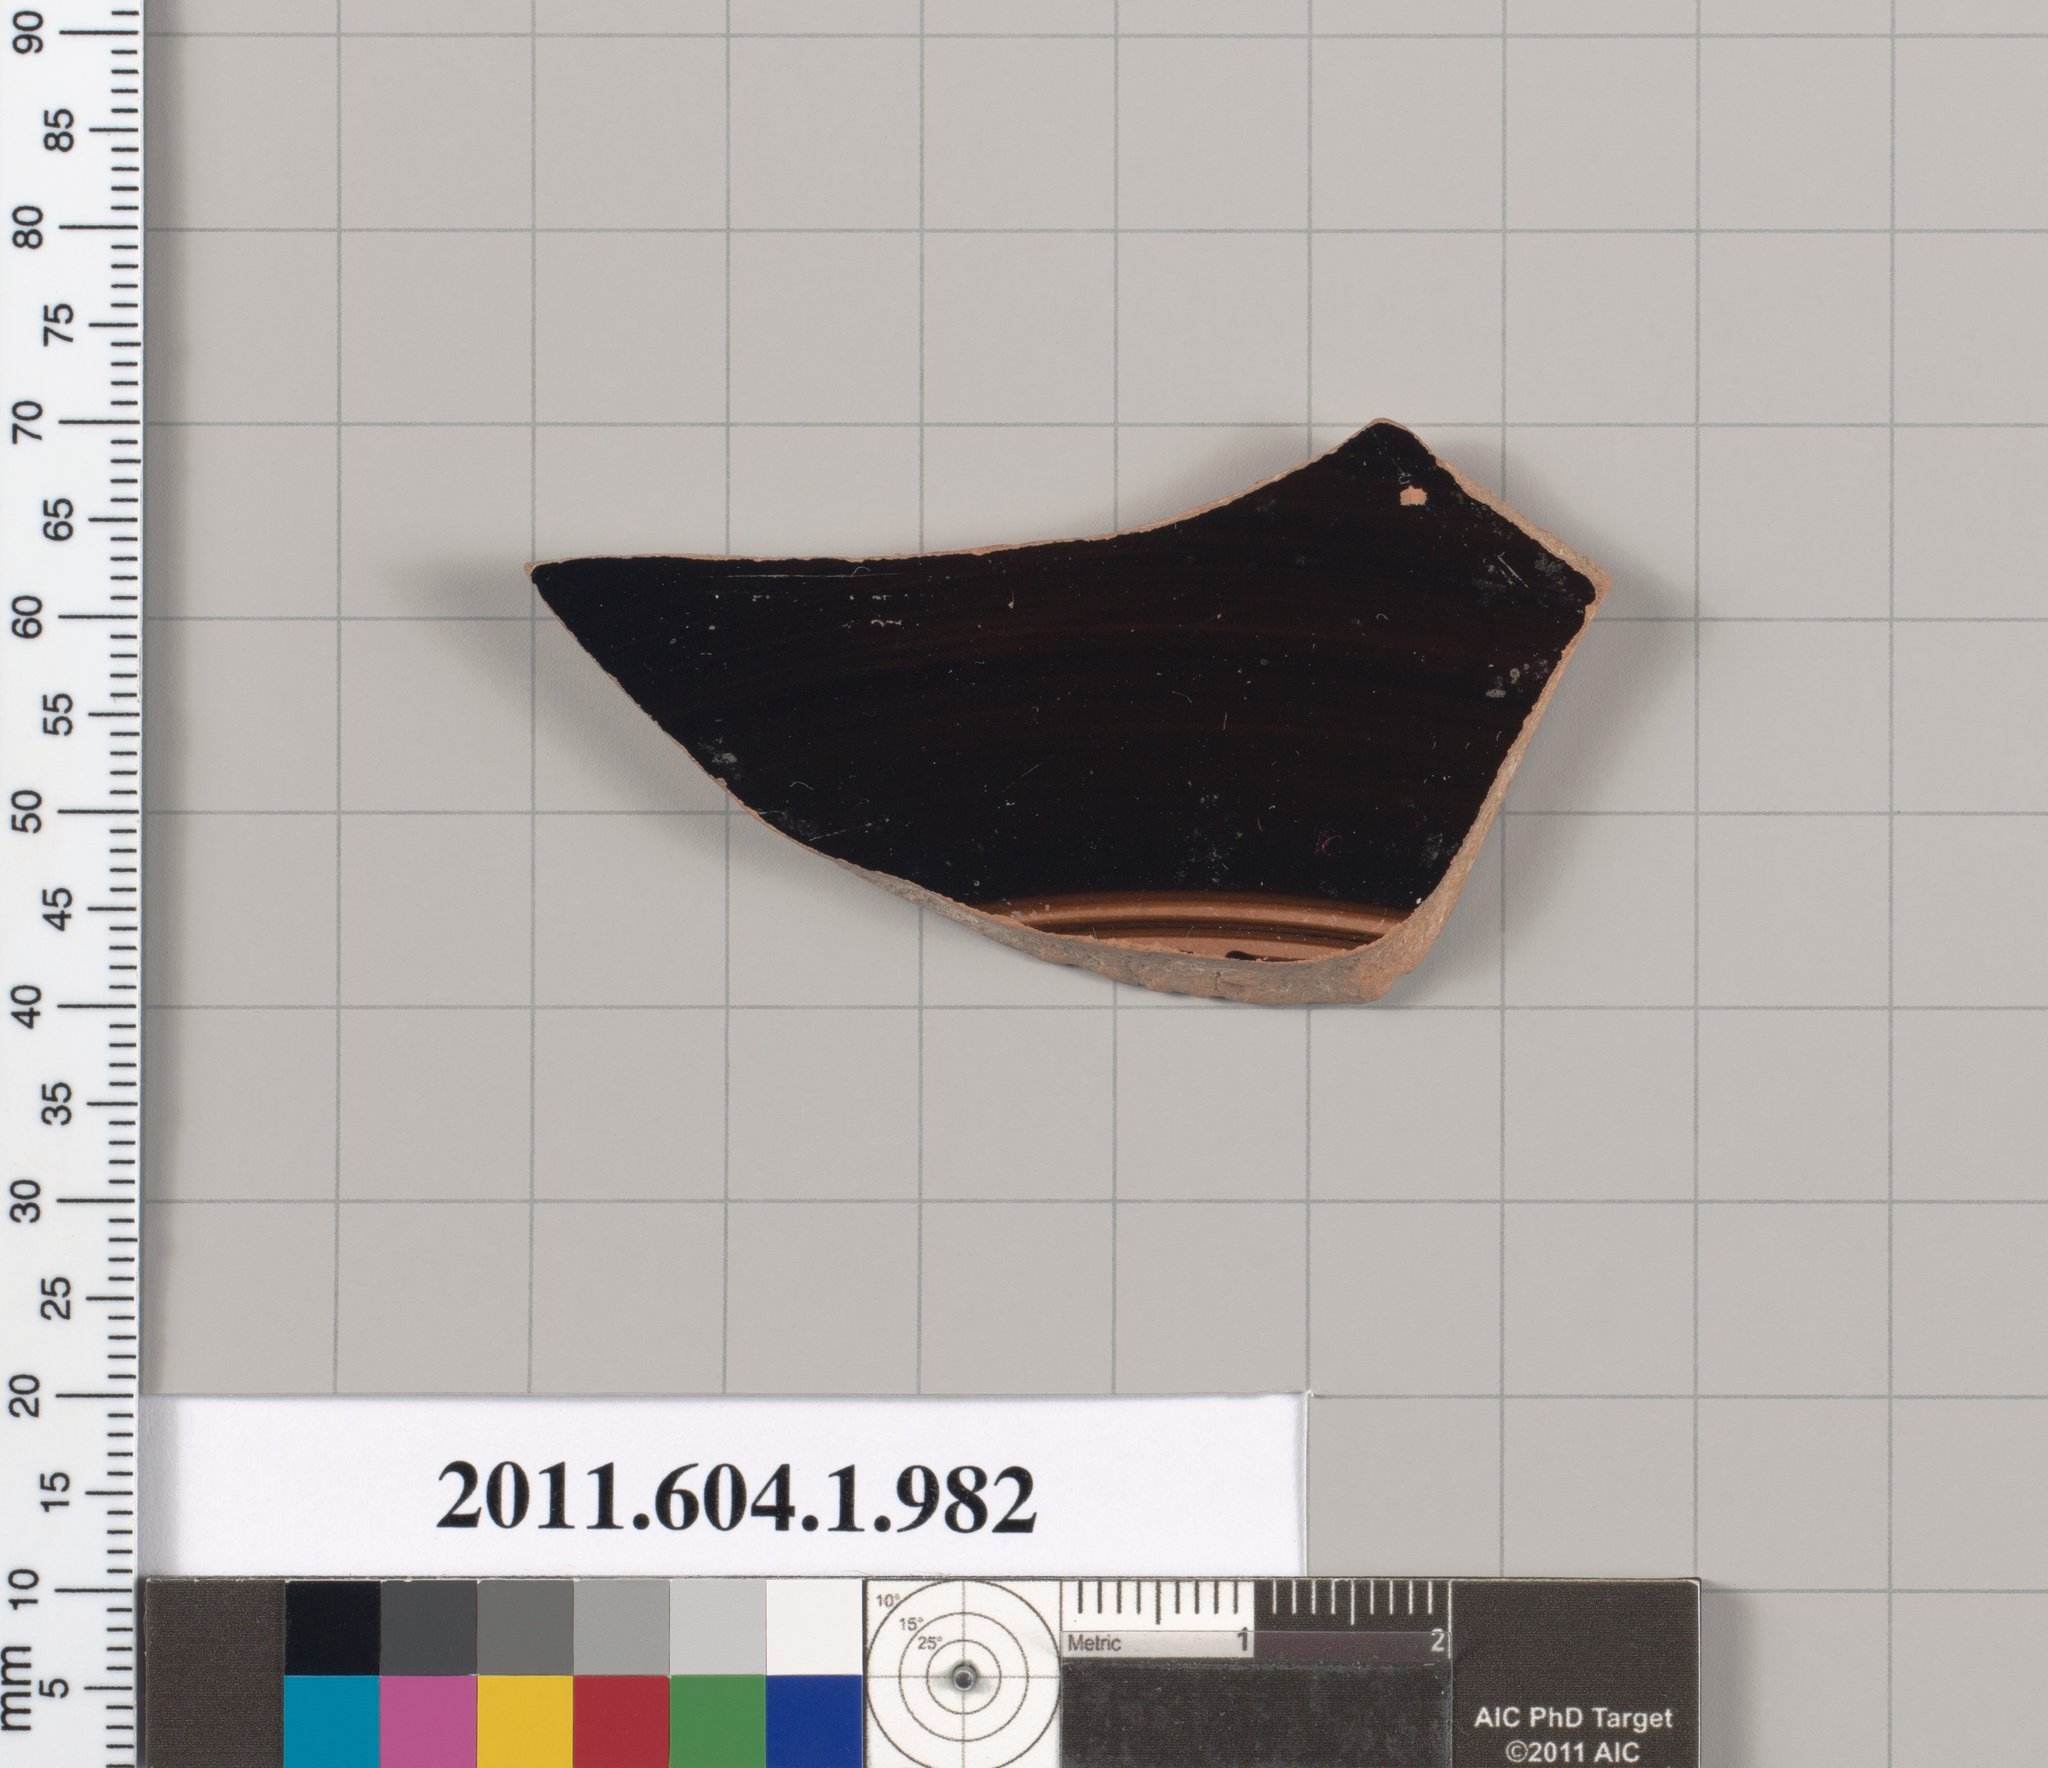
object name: kylix fragment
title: Terracotta fragment of a kylix (drinking cup)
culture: greek, attic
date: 490-480 BCE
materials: terracotta